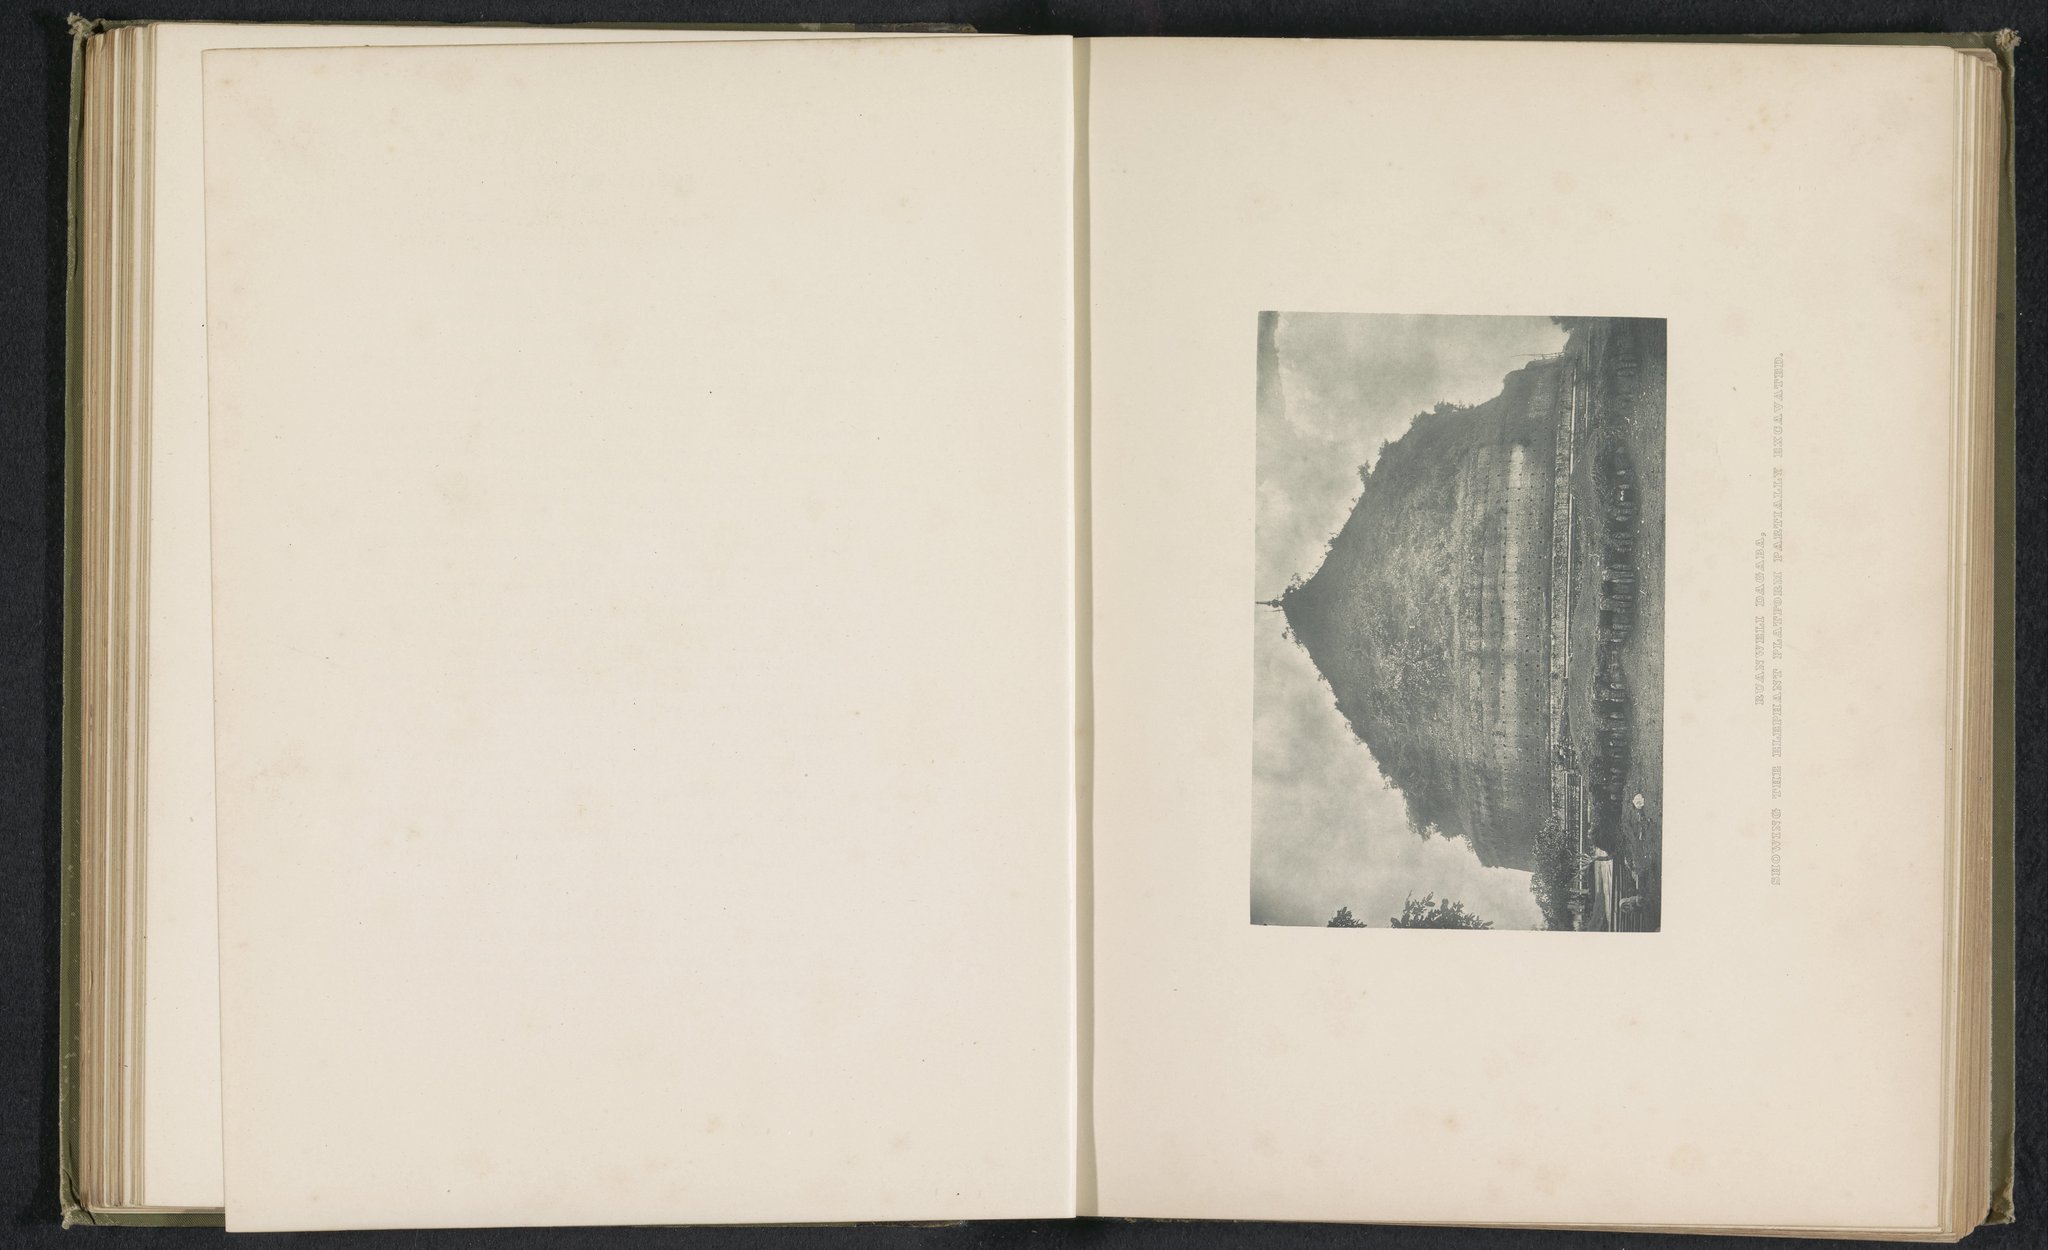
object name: page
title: Ruins of the Ruwanwelisaya stupa at Anuradhapura, Sri Lanka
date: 1896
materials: paper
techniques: woodburygravure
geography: anuradhapura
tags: temple, shrine ~ hinduism, buddhism, jainism, ruin of a building ~ architecture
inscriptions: title: ‘RUANWELI DAGABA,/ SHOWING THE ELEPHANT PLATFORM PARTIALLY EXCAVATED.’